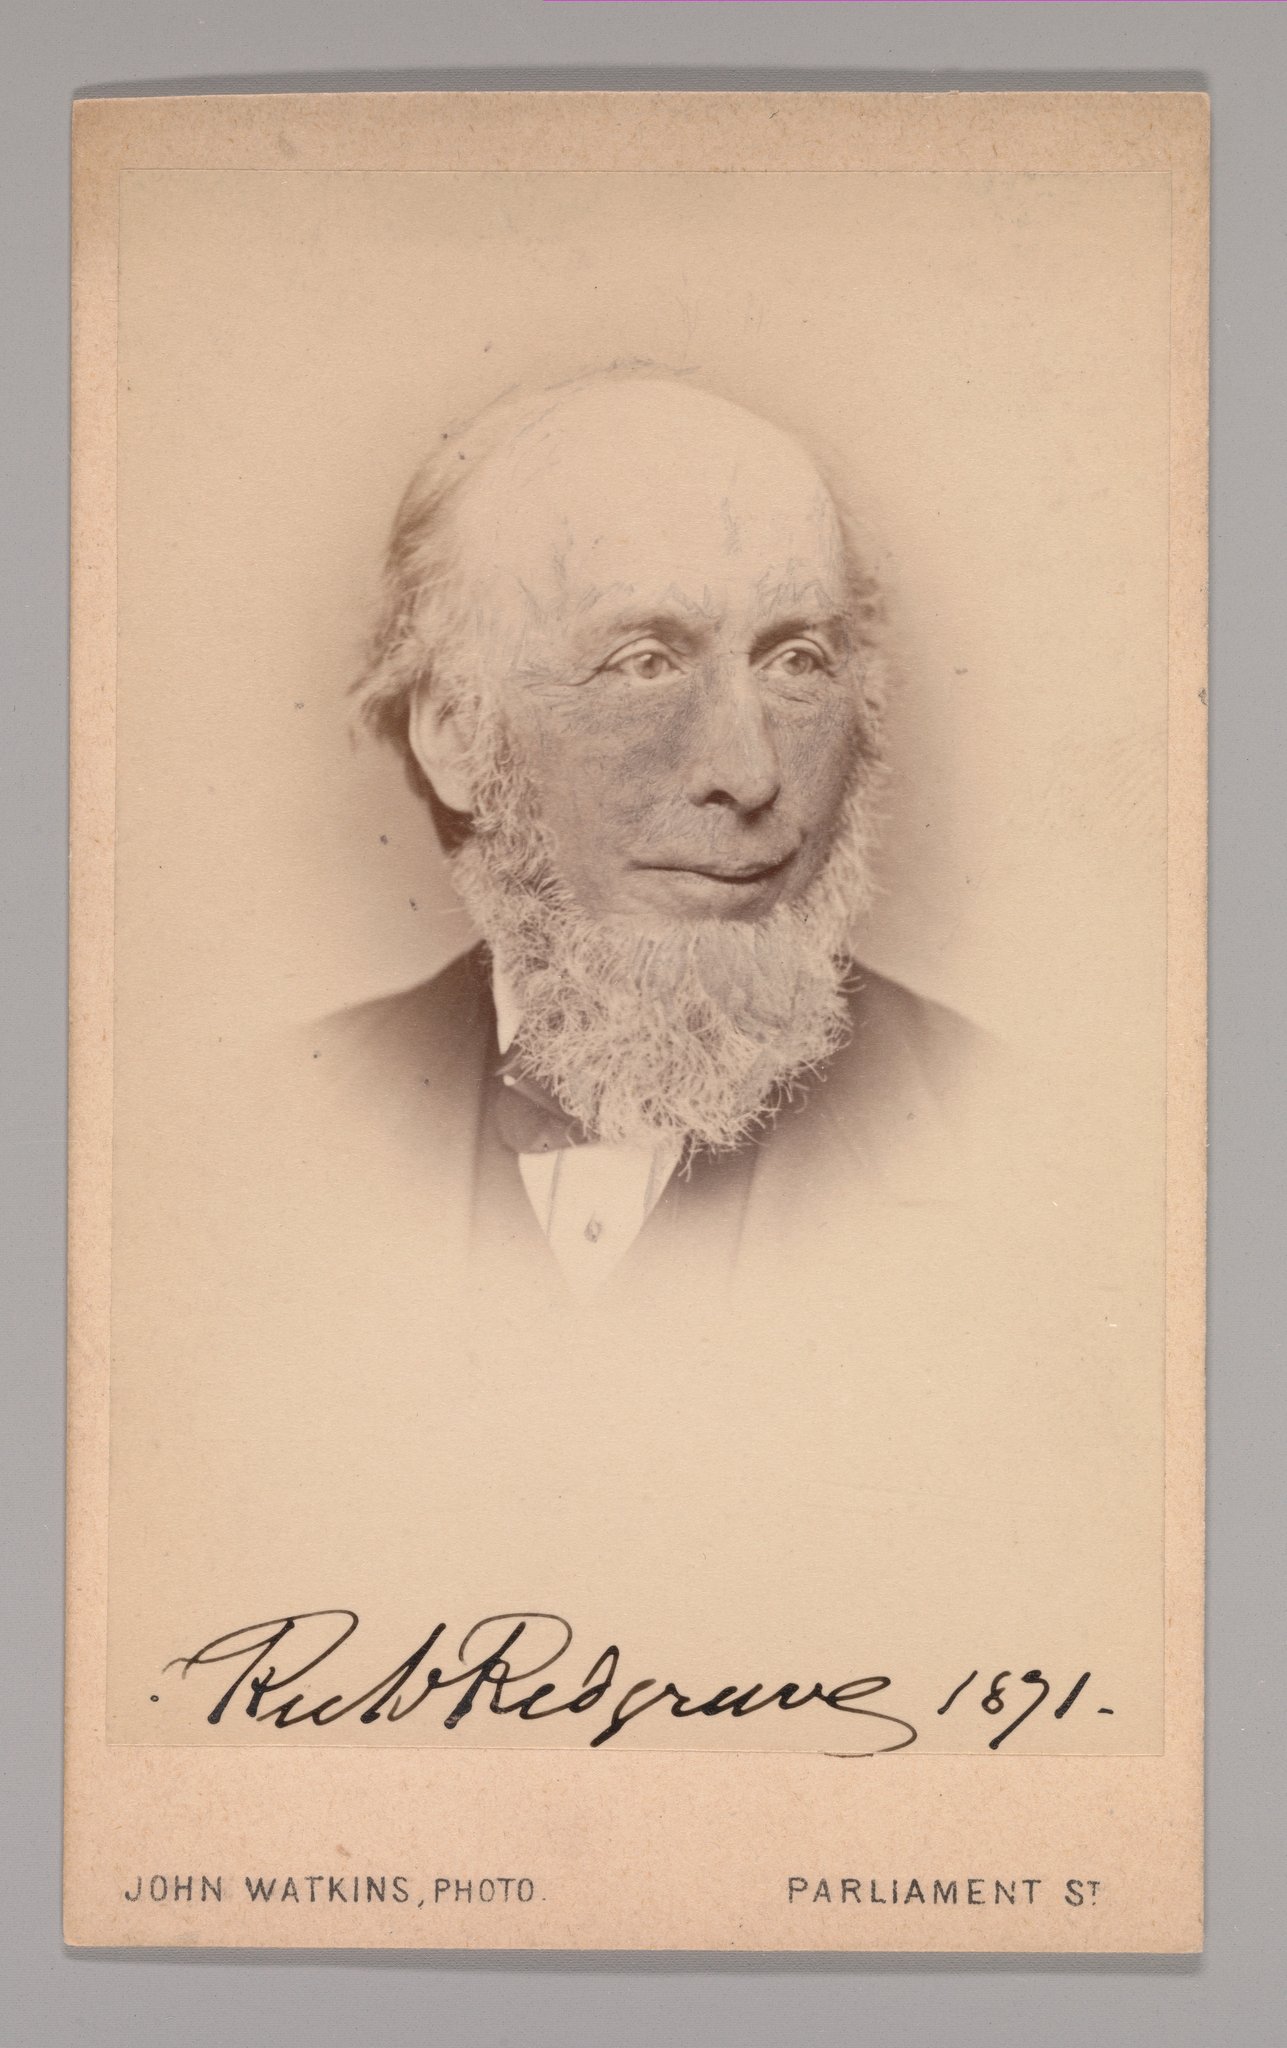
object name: carte de visite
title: [Richard Redgrave]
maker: john and charles watkins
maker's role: photography studio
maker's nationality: british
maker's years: 1840-1875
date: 1860-1869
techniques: albumen silver print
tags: men,portraits